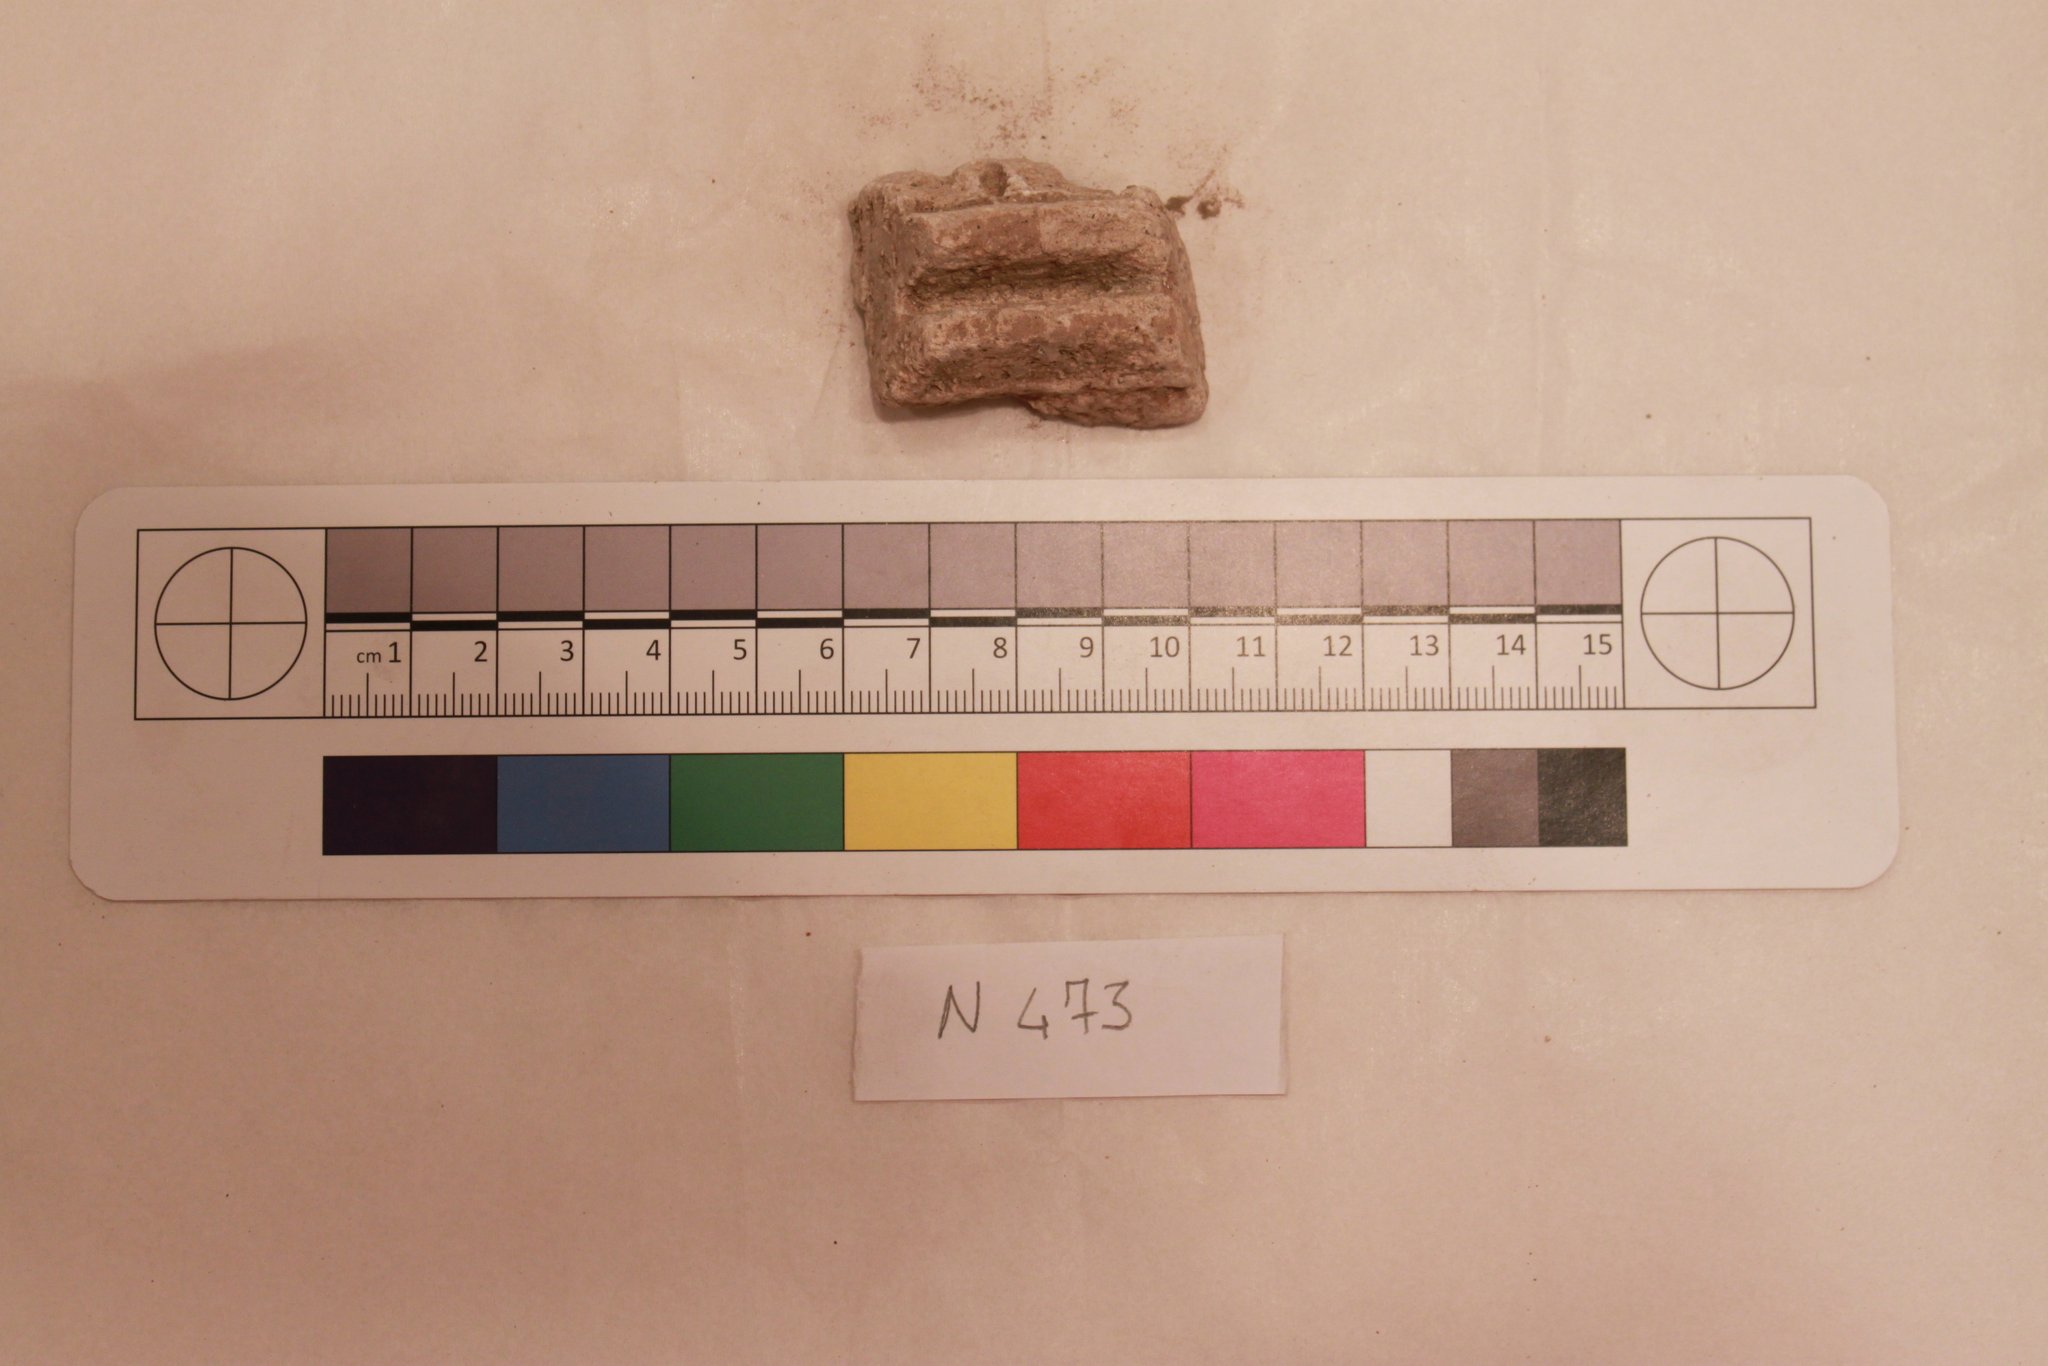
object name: fragment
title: Stucco Fragment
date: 701-1200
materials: plaster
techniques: carving, painting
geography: iran